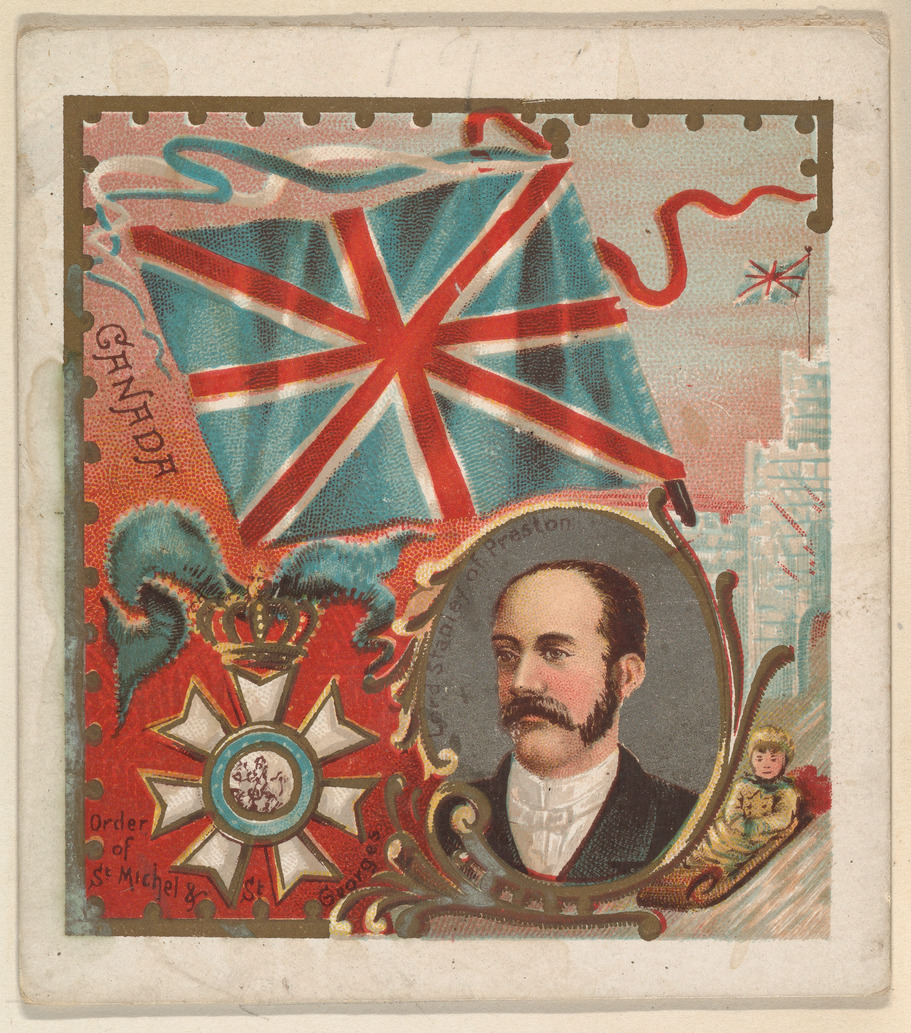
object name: print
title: Canada, from the International Cards series (N238), issued by Kinney Bros.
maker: kinney brothers tobacco company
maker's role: publisher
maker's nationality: american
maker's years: 1869-2011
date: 1888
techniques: color lithograph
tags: men,flags